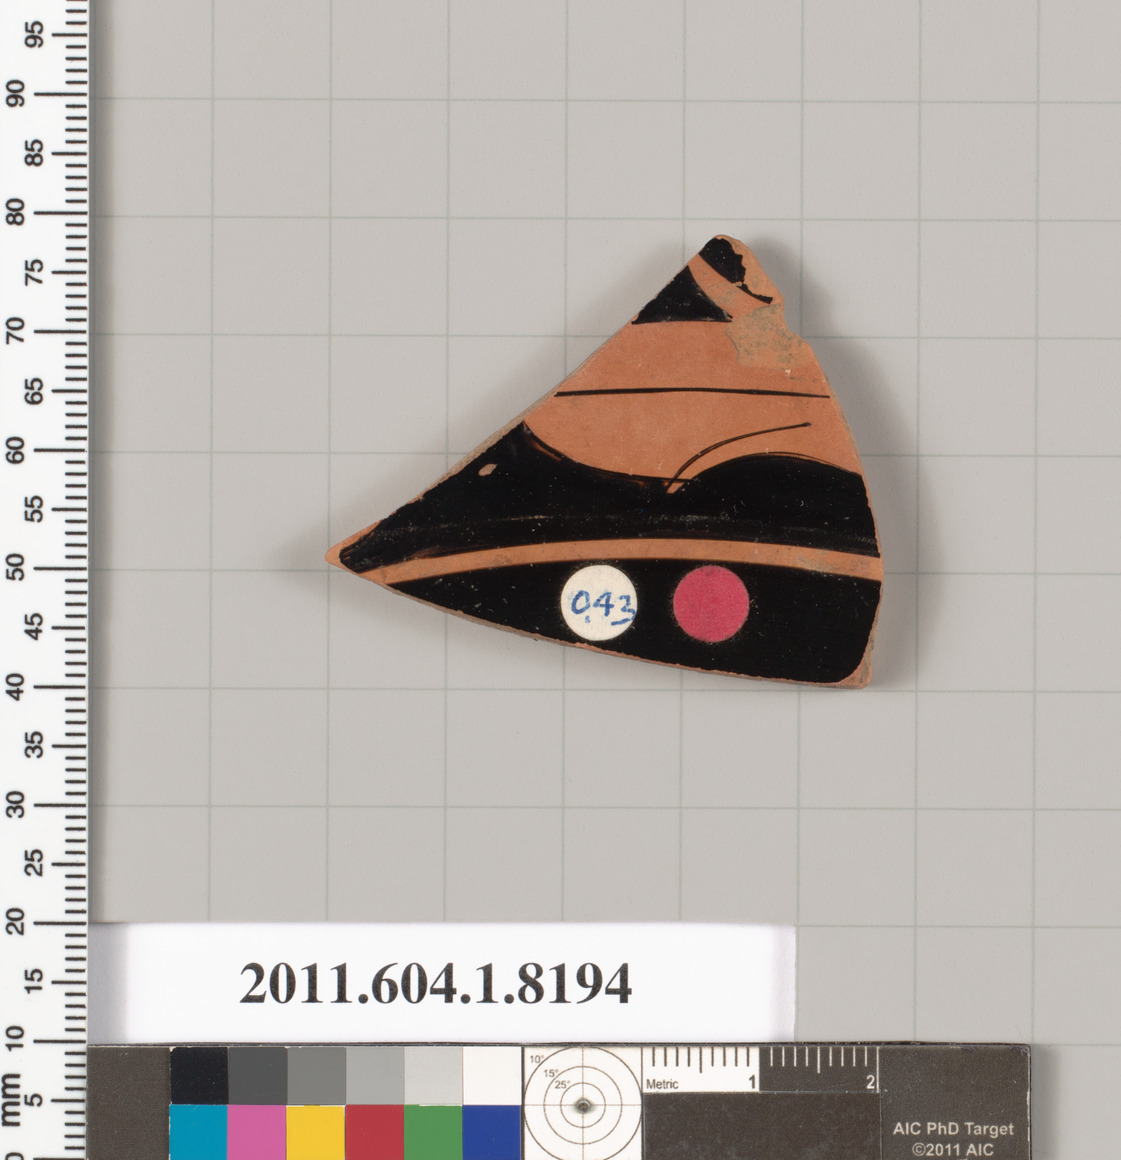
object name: kylix fragment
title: Terracotta fragment of a kylix (drinking cup)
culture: greek, attic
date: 520-510 BCE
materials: terracotta